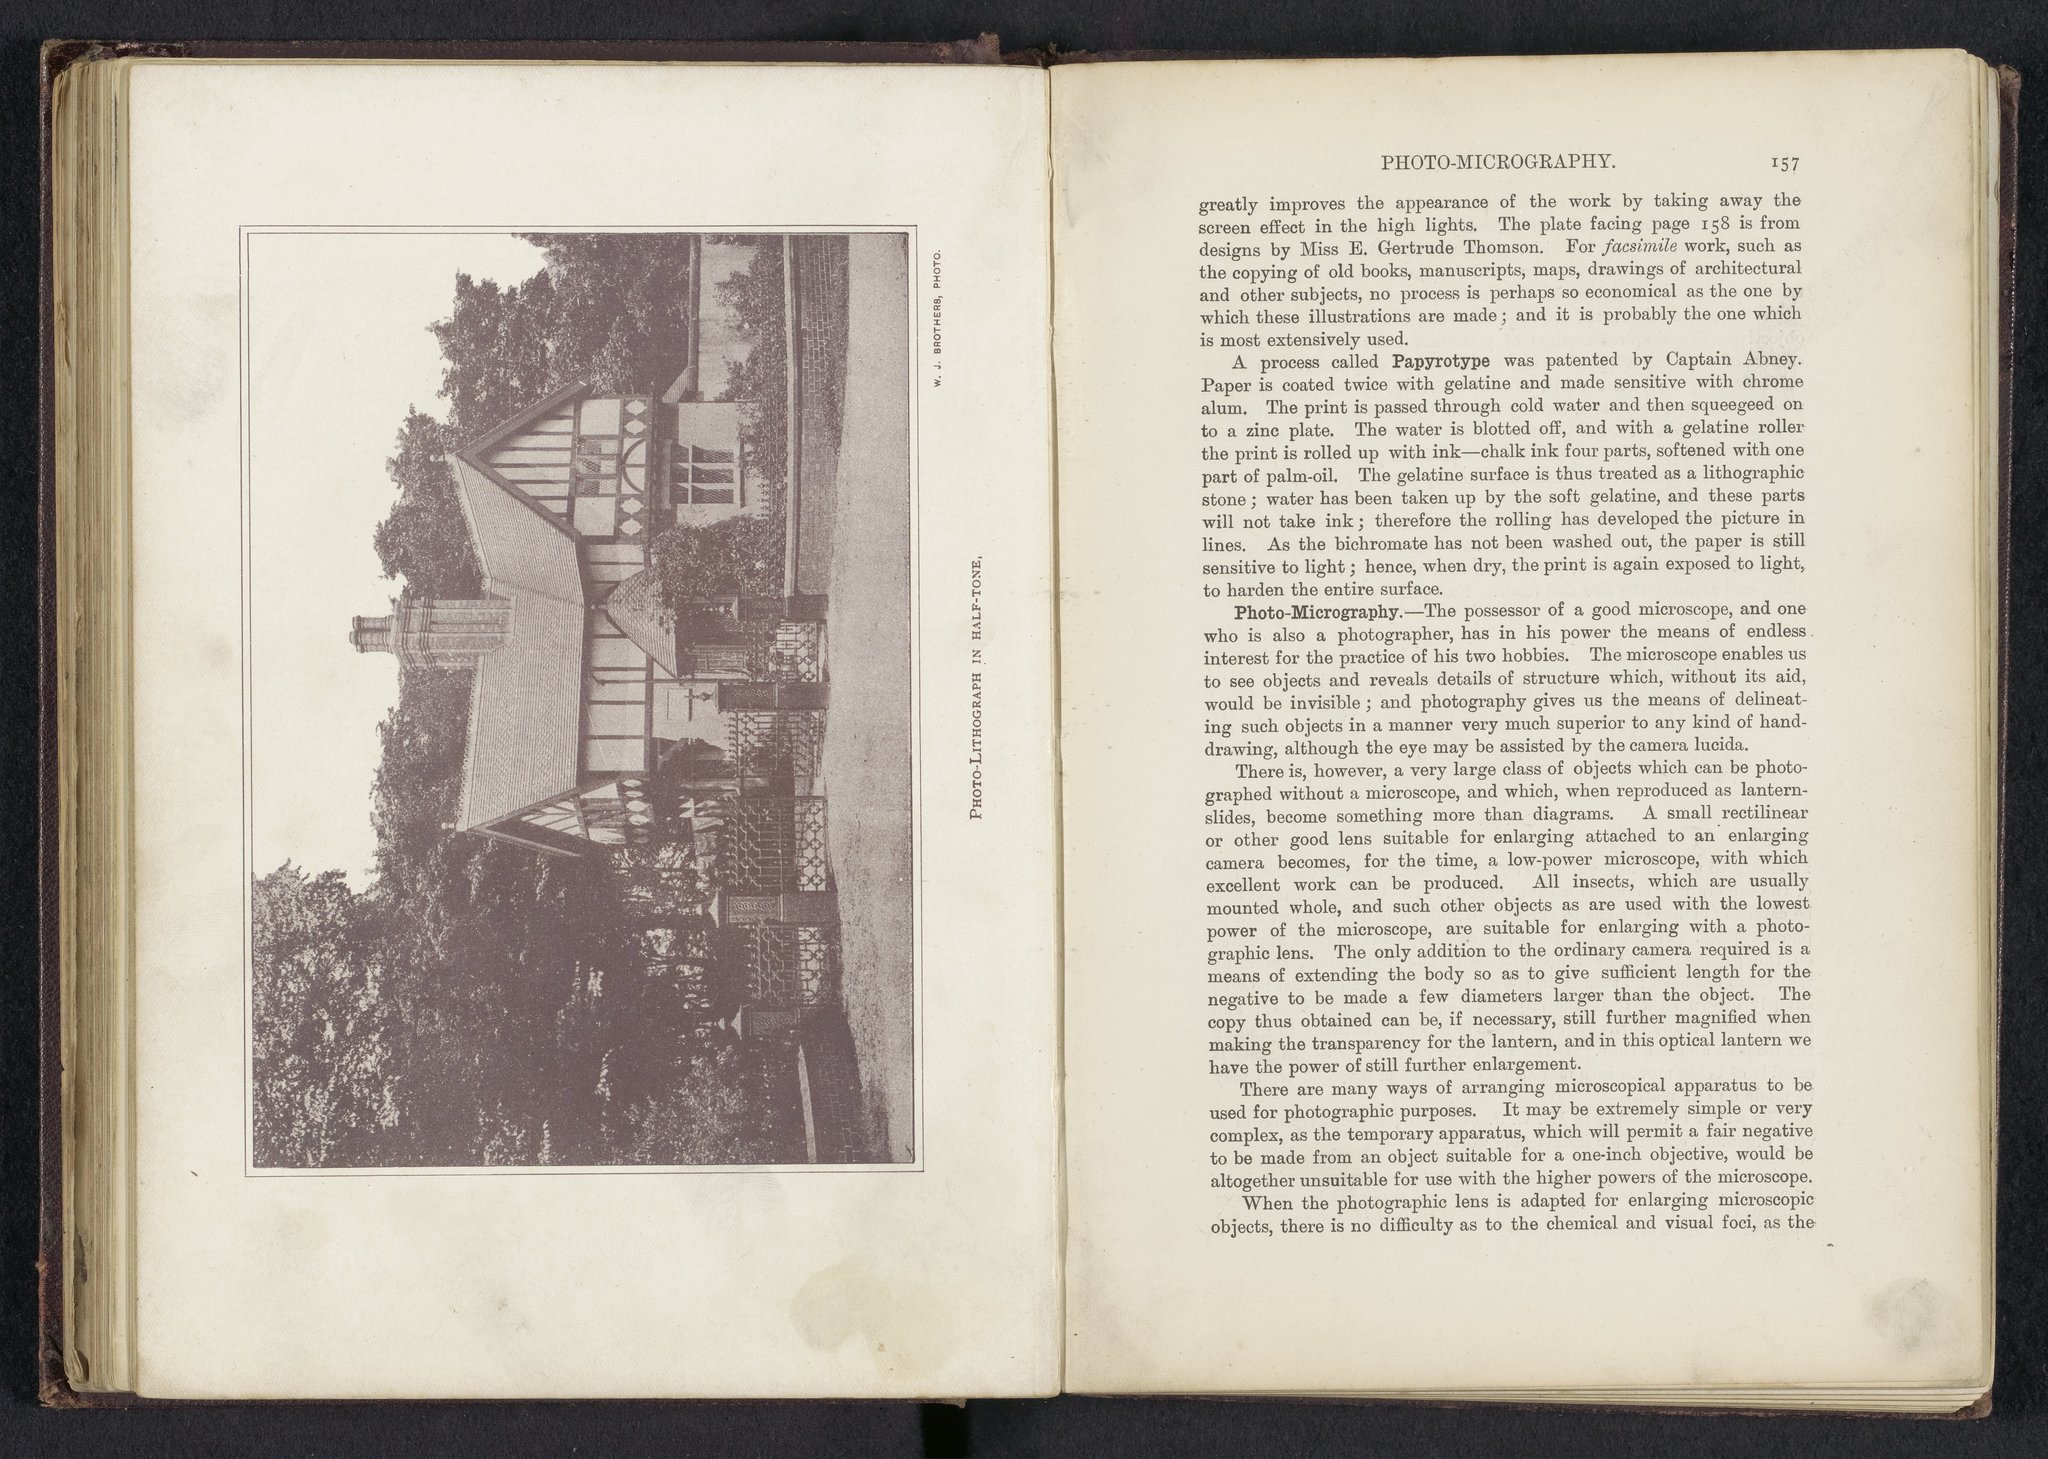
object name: page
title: Exterieur van een woonhuis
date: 1889-1899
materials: paper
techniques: autotype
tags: housing, façade (of house or building)